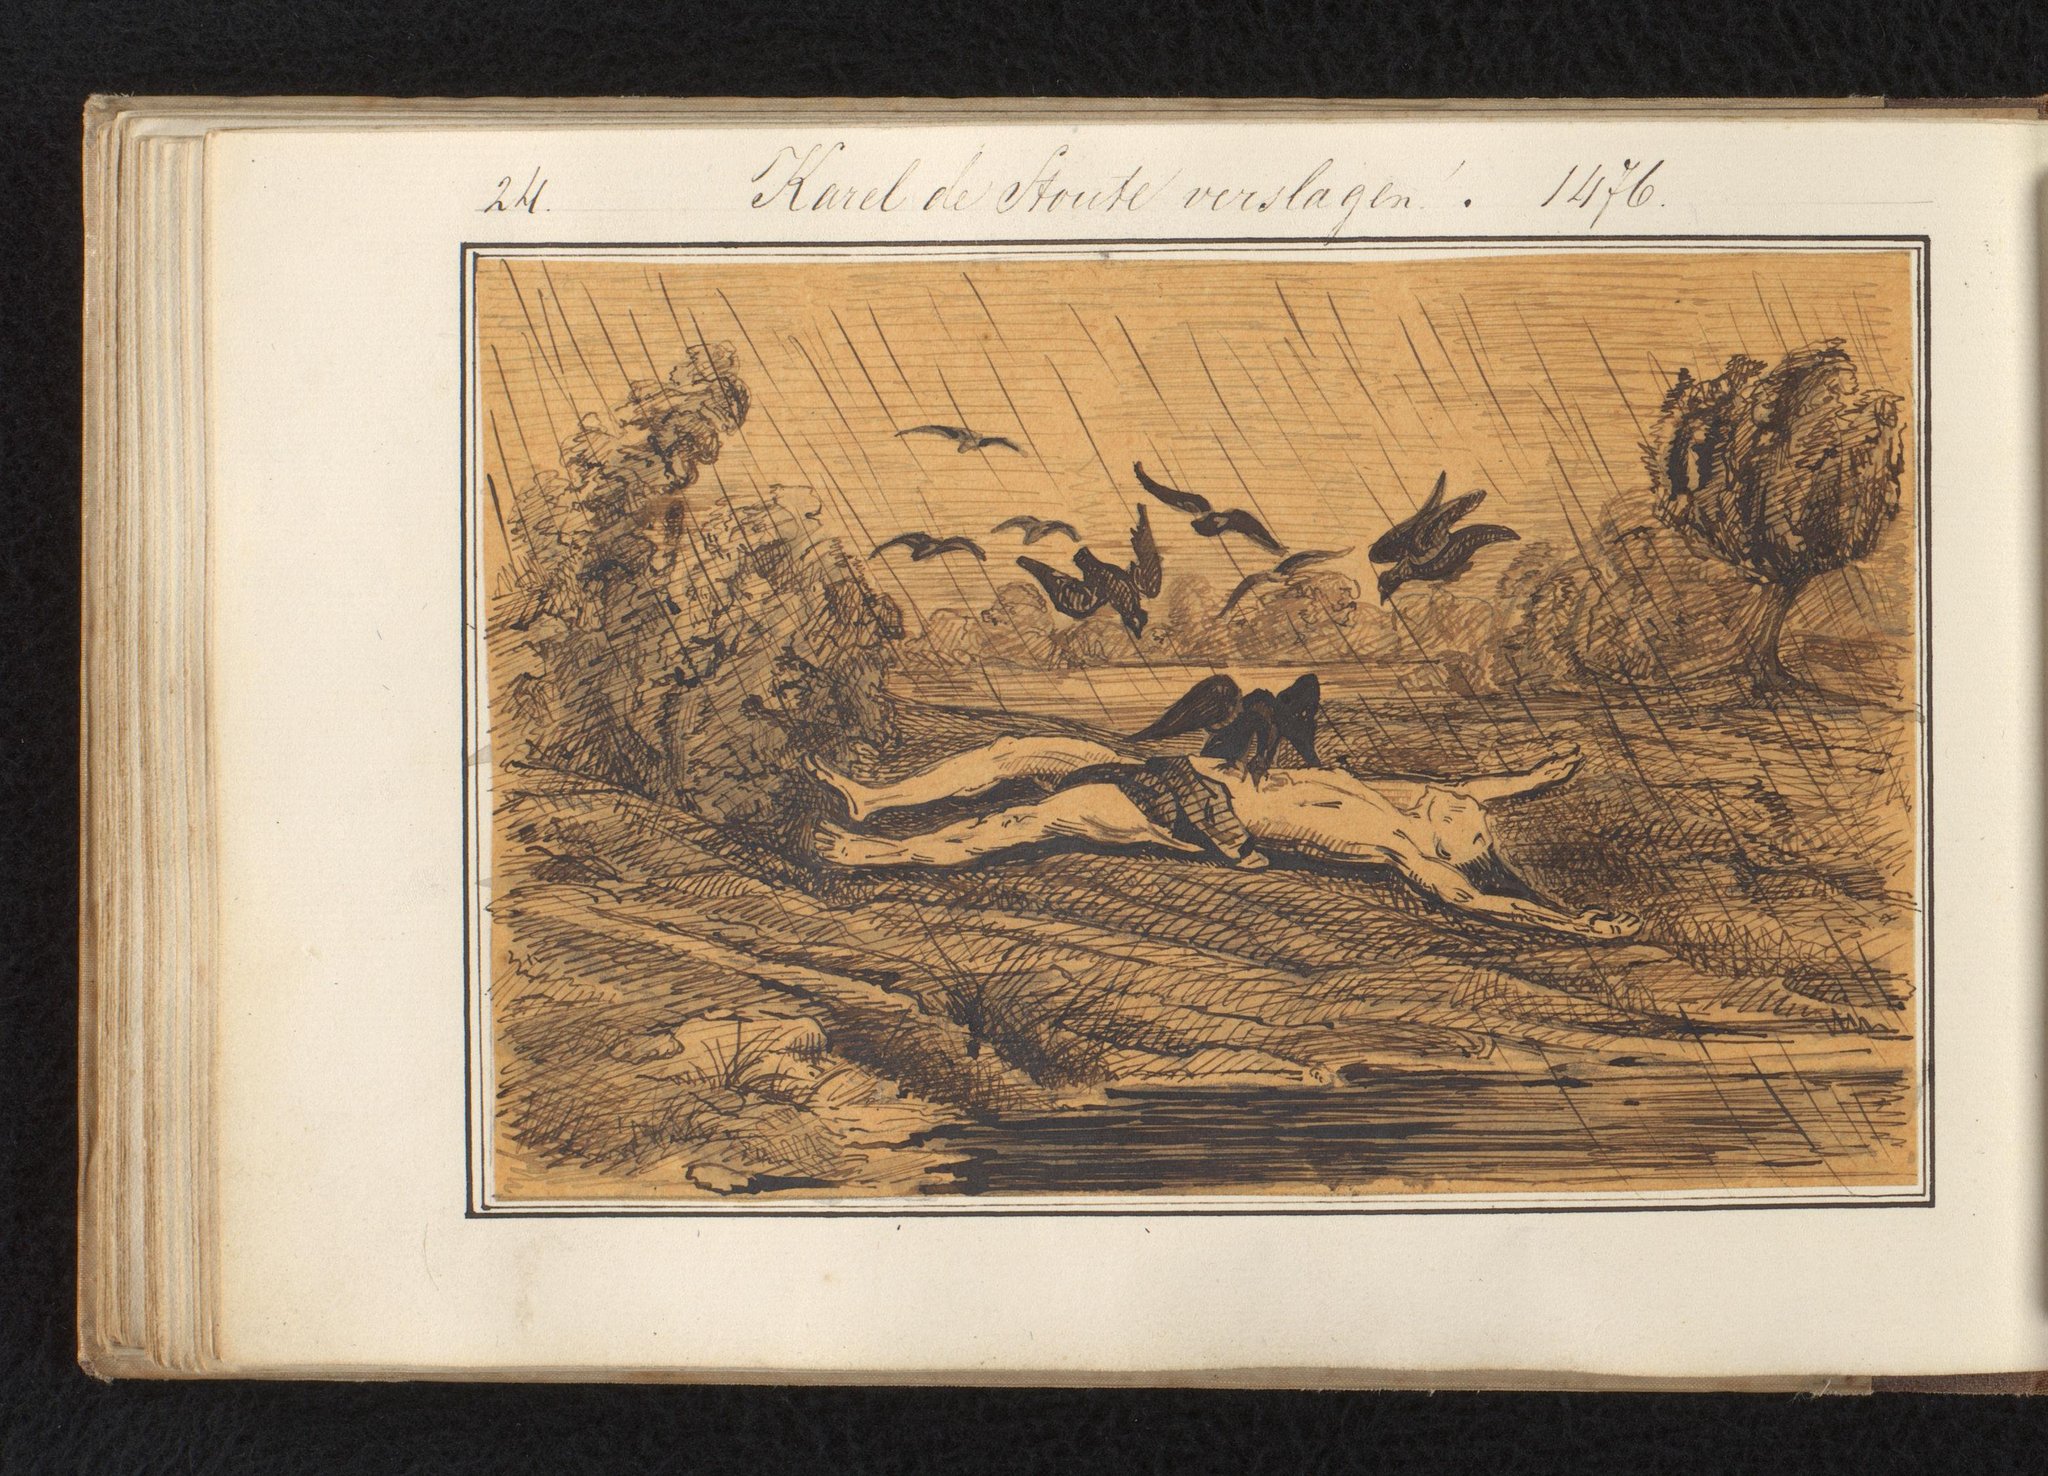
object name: drawing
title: Lijk van Karel de Stoute, hertog van Bourgondië, met kraaien, 1476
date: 1853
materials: ink, pencil, paper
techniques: brush, pen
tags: earl, charles the bold (duke of burgundy), song-birds: crow, (corpse of) man eaten by animals, the corpse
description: Ontwerp voor: Lennep, Jacob van. Tafereelen uit de geschiedenis des vaderlands, tot nut van groot en klein. Amsterdam: M.H. Binger en Zonen, 1854.